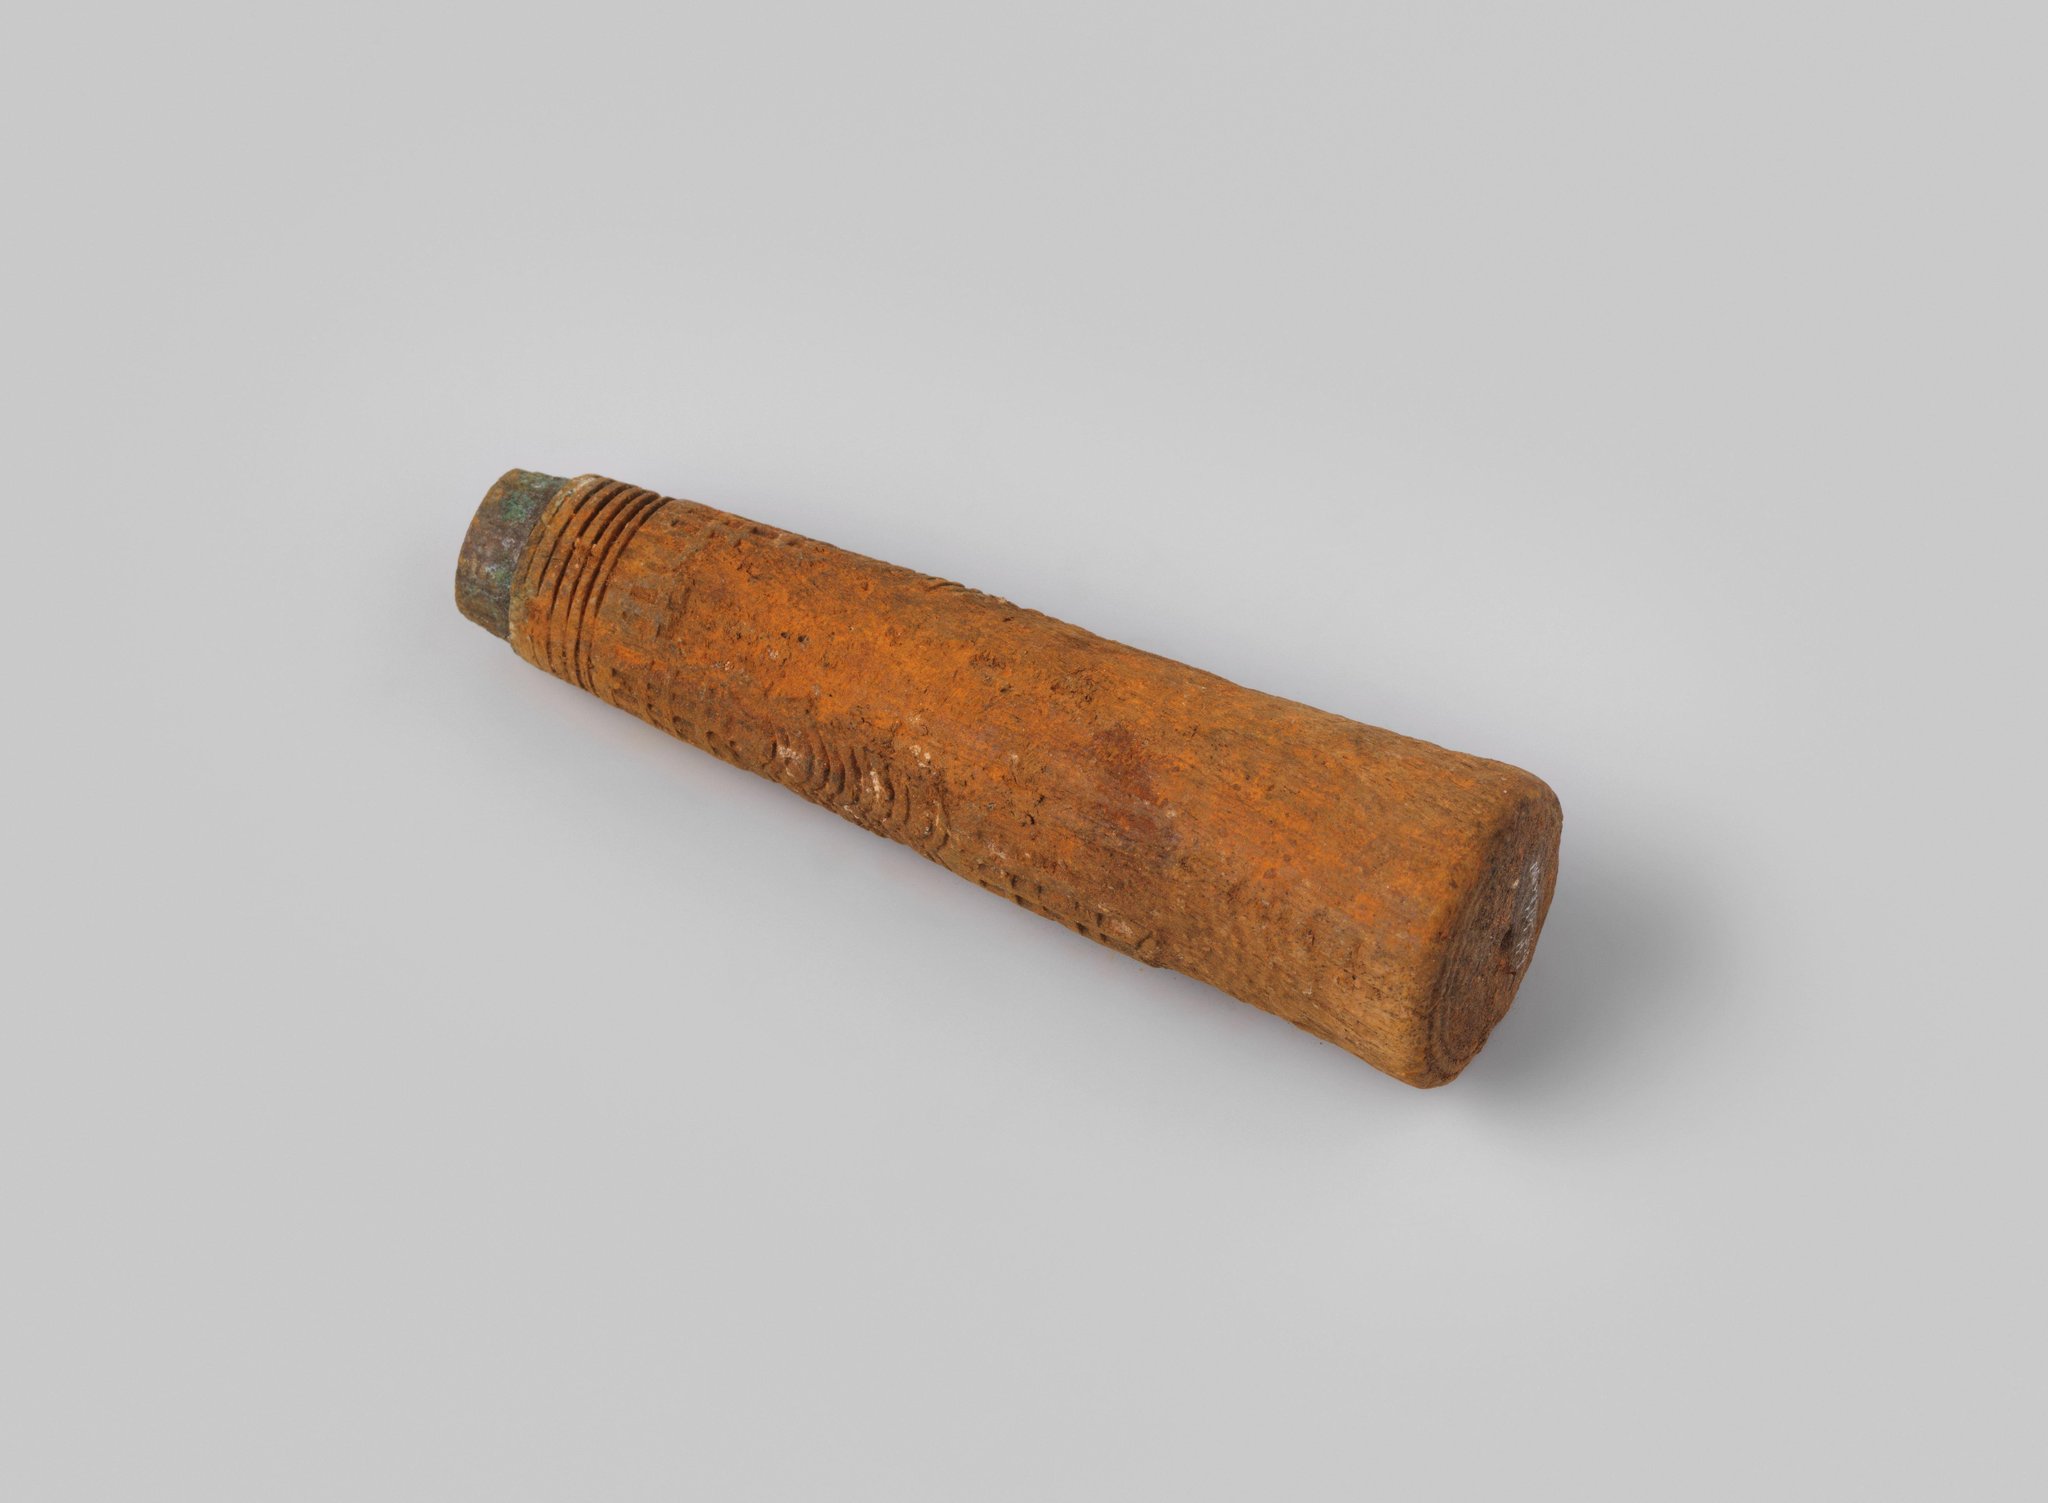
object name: knife handle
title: Messenheft uit het wrak van de Oost-Indiëvaarder Hollandia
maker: Anonymous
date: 1700-1743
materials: wood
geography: netherlands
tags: verenigde oostindische compagnie, hollandia (schip), annet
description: Knife, handle, cylindrical: tapering; id. NG 1979-403H, ferrules id. NG 1980-27H426.